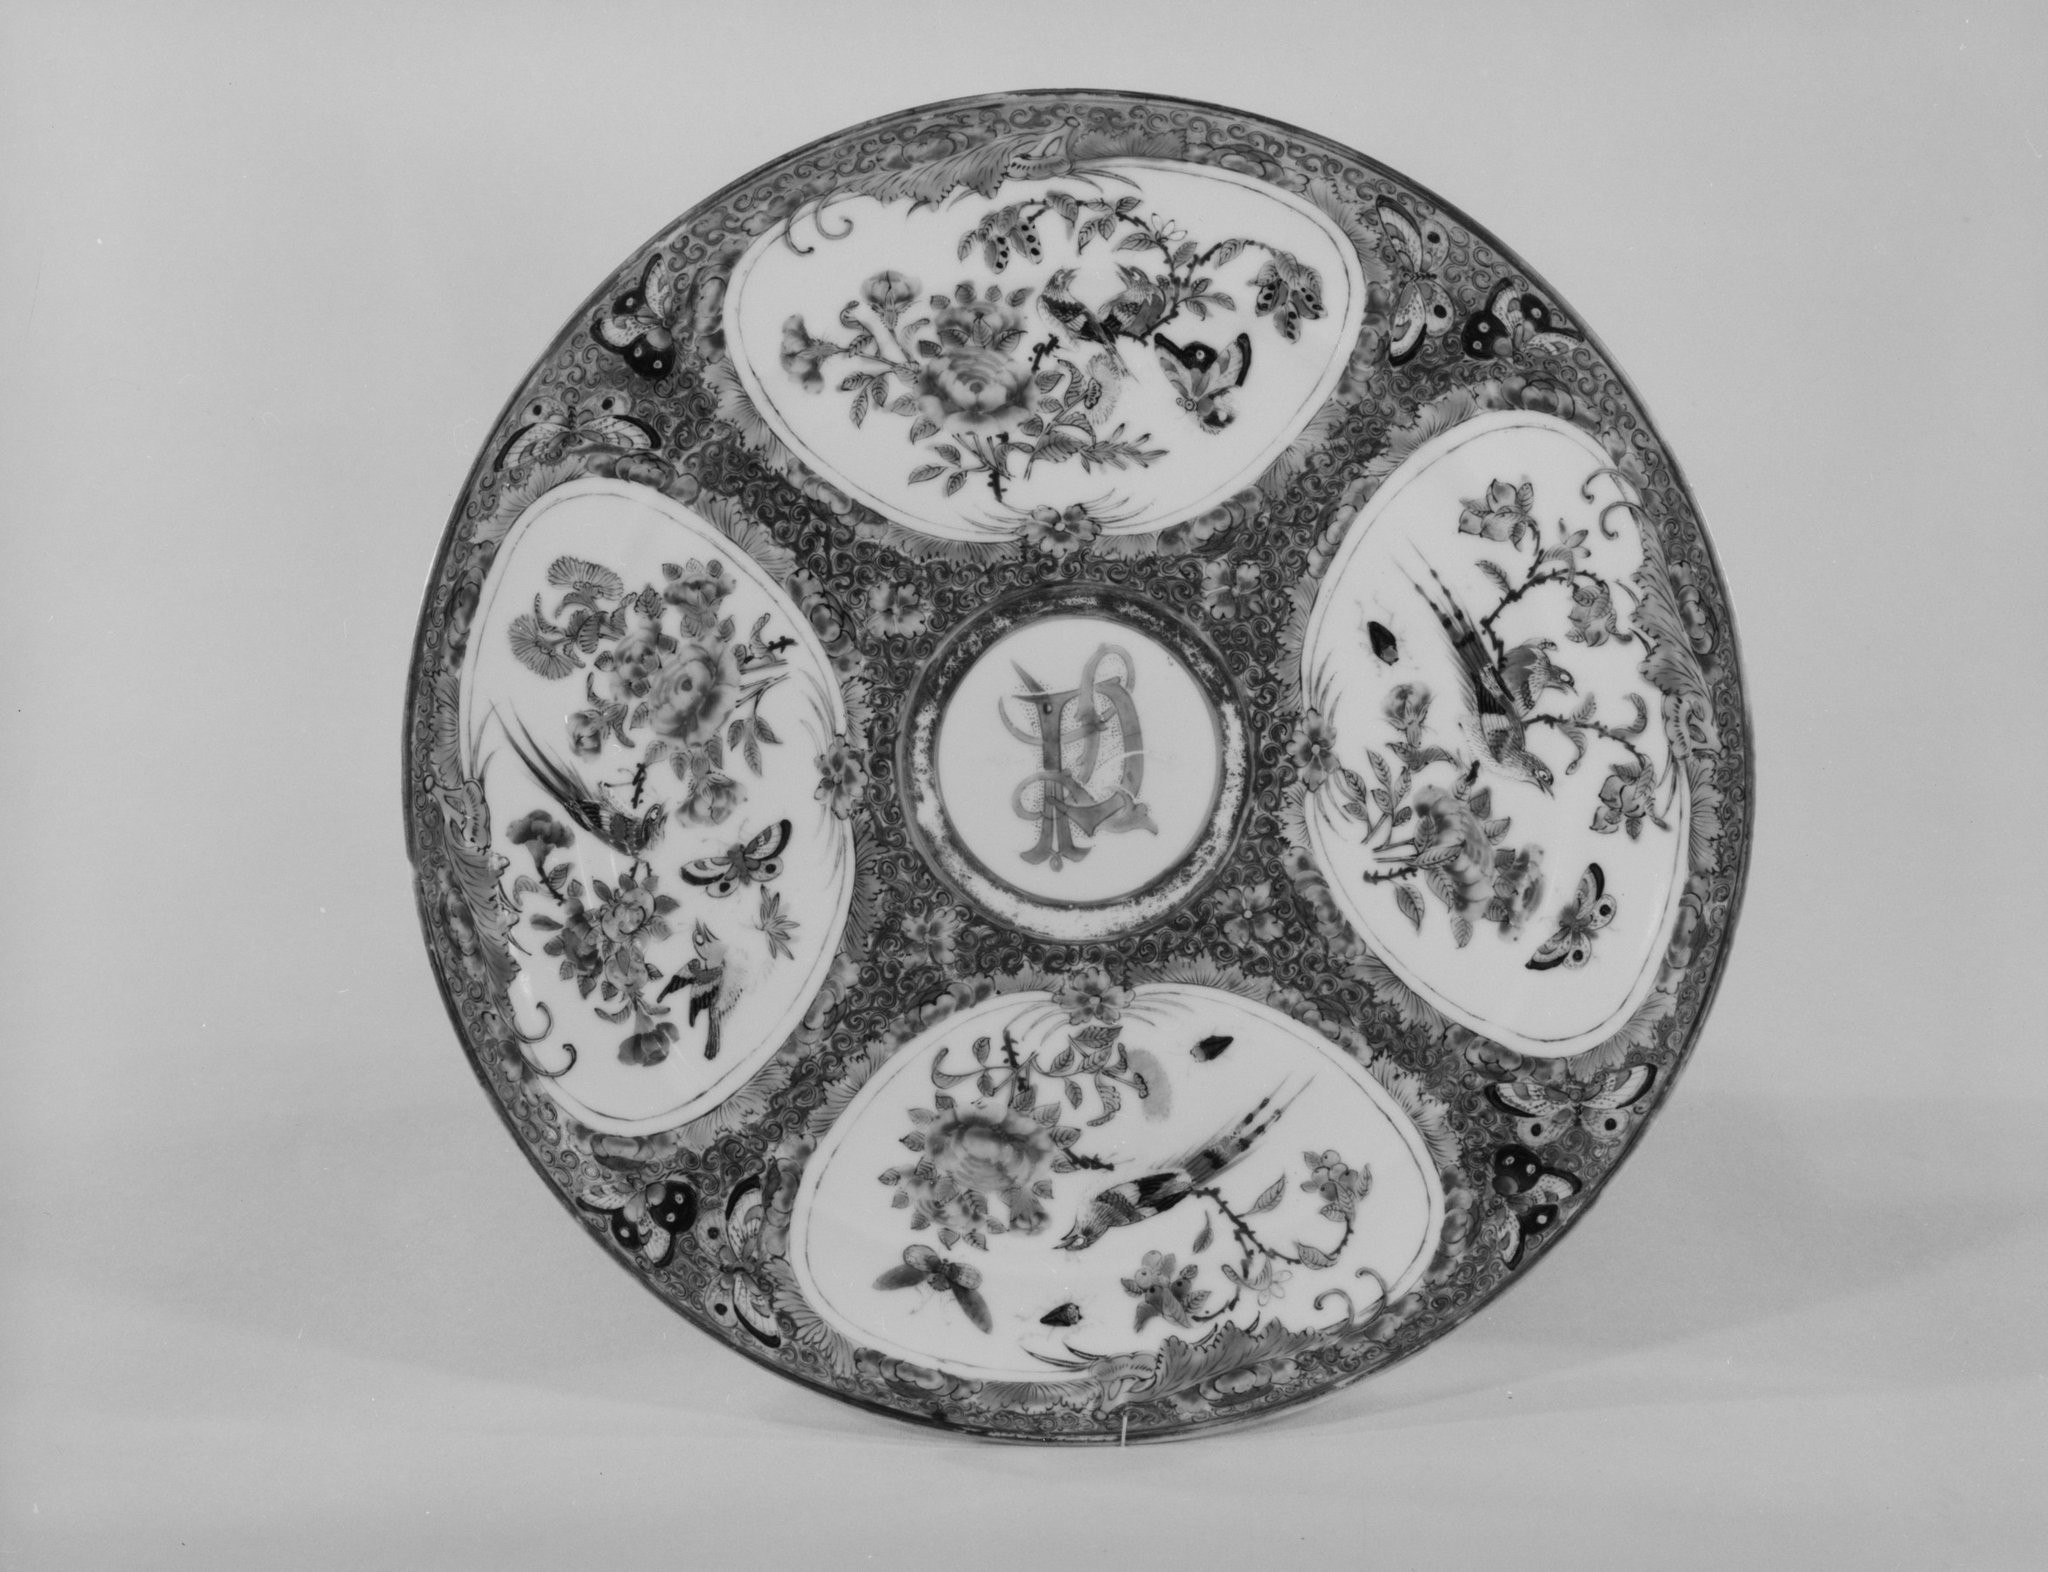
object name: plate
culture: chinese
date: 1860-1866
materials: porcelain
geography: china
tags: birds,butterflies,flowers